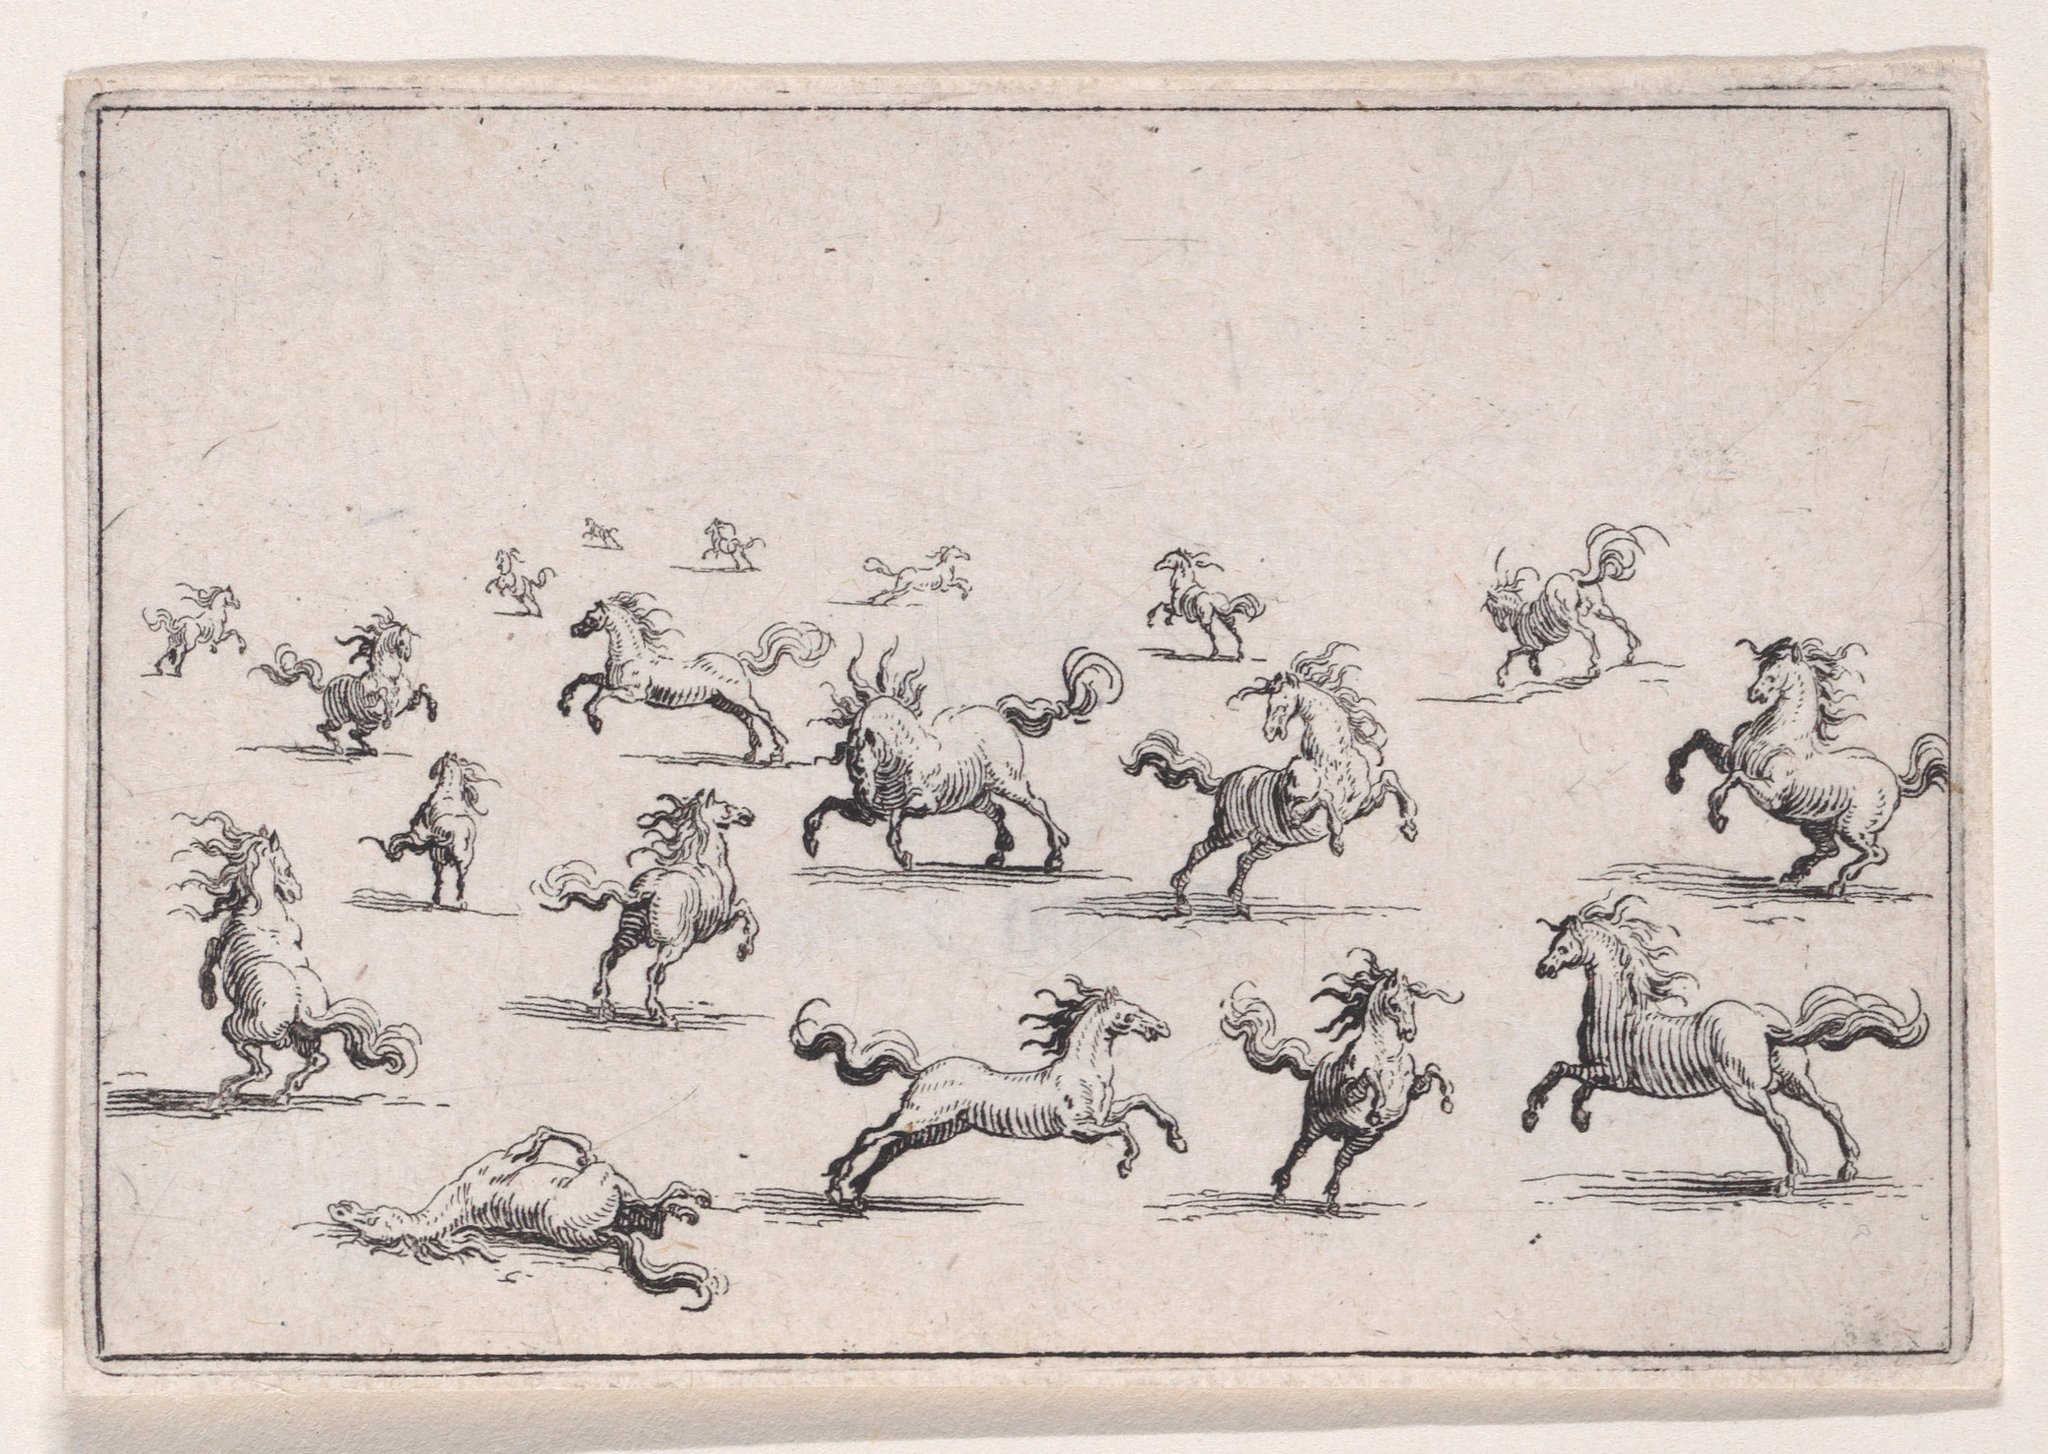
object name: print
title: Chevaux Courant en Liberté (Horses Running Freely), from Les Caprices Series B, The Nancy Set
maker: jacques callot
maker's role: artist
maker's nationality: french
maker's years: 1592-1635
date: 1617-1620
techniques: etching